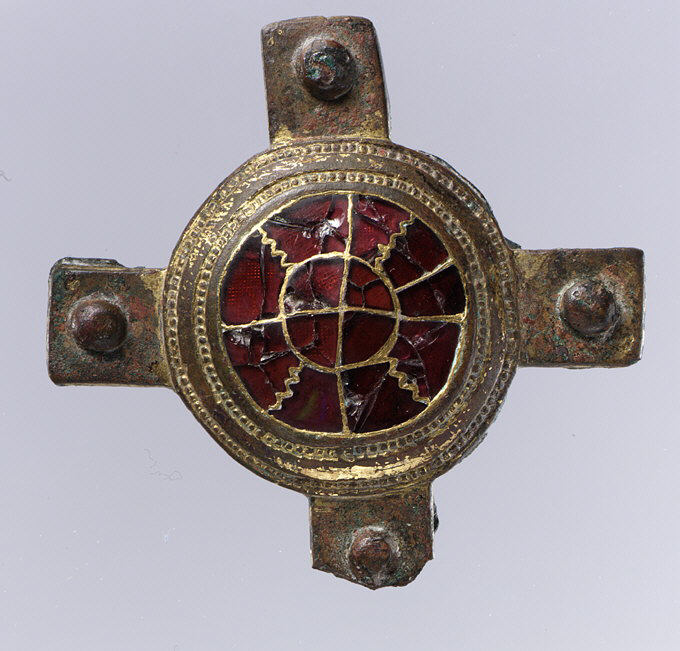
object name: strap mount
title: Cloisonné Strap Mount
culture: frankish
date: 501-550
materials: copper alloy, gilt, gold